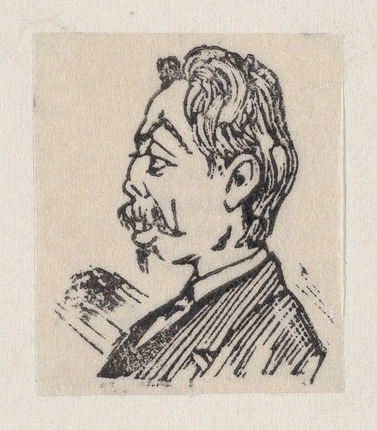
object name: print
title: Profile of a man with a beard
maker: josé guadalupe posada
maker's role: artist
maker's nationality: mexican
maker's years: 1852-1913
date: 1880-1910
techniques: woodcut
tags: men,profiles